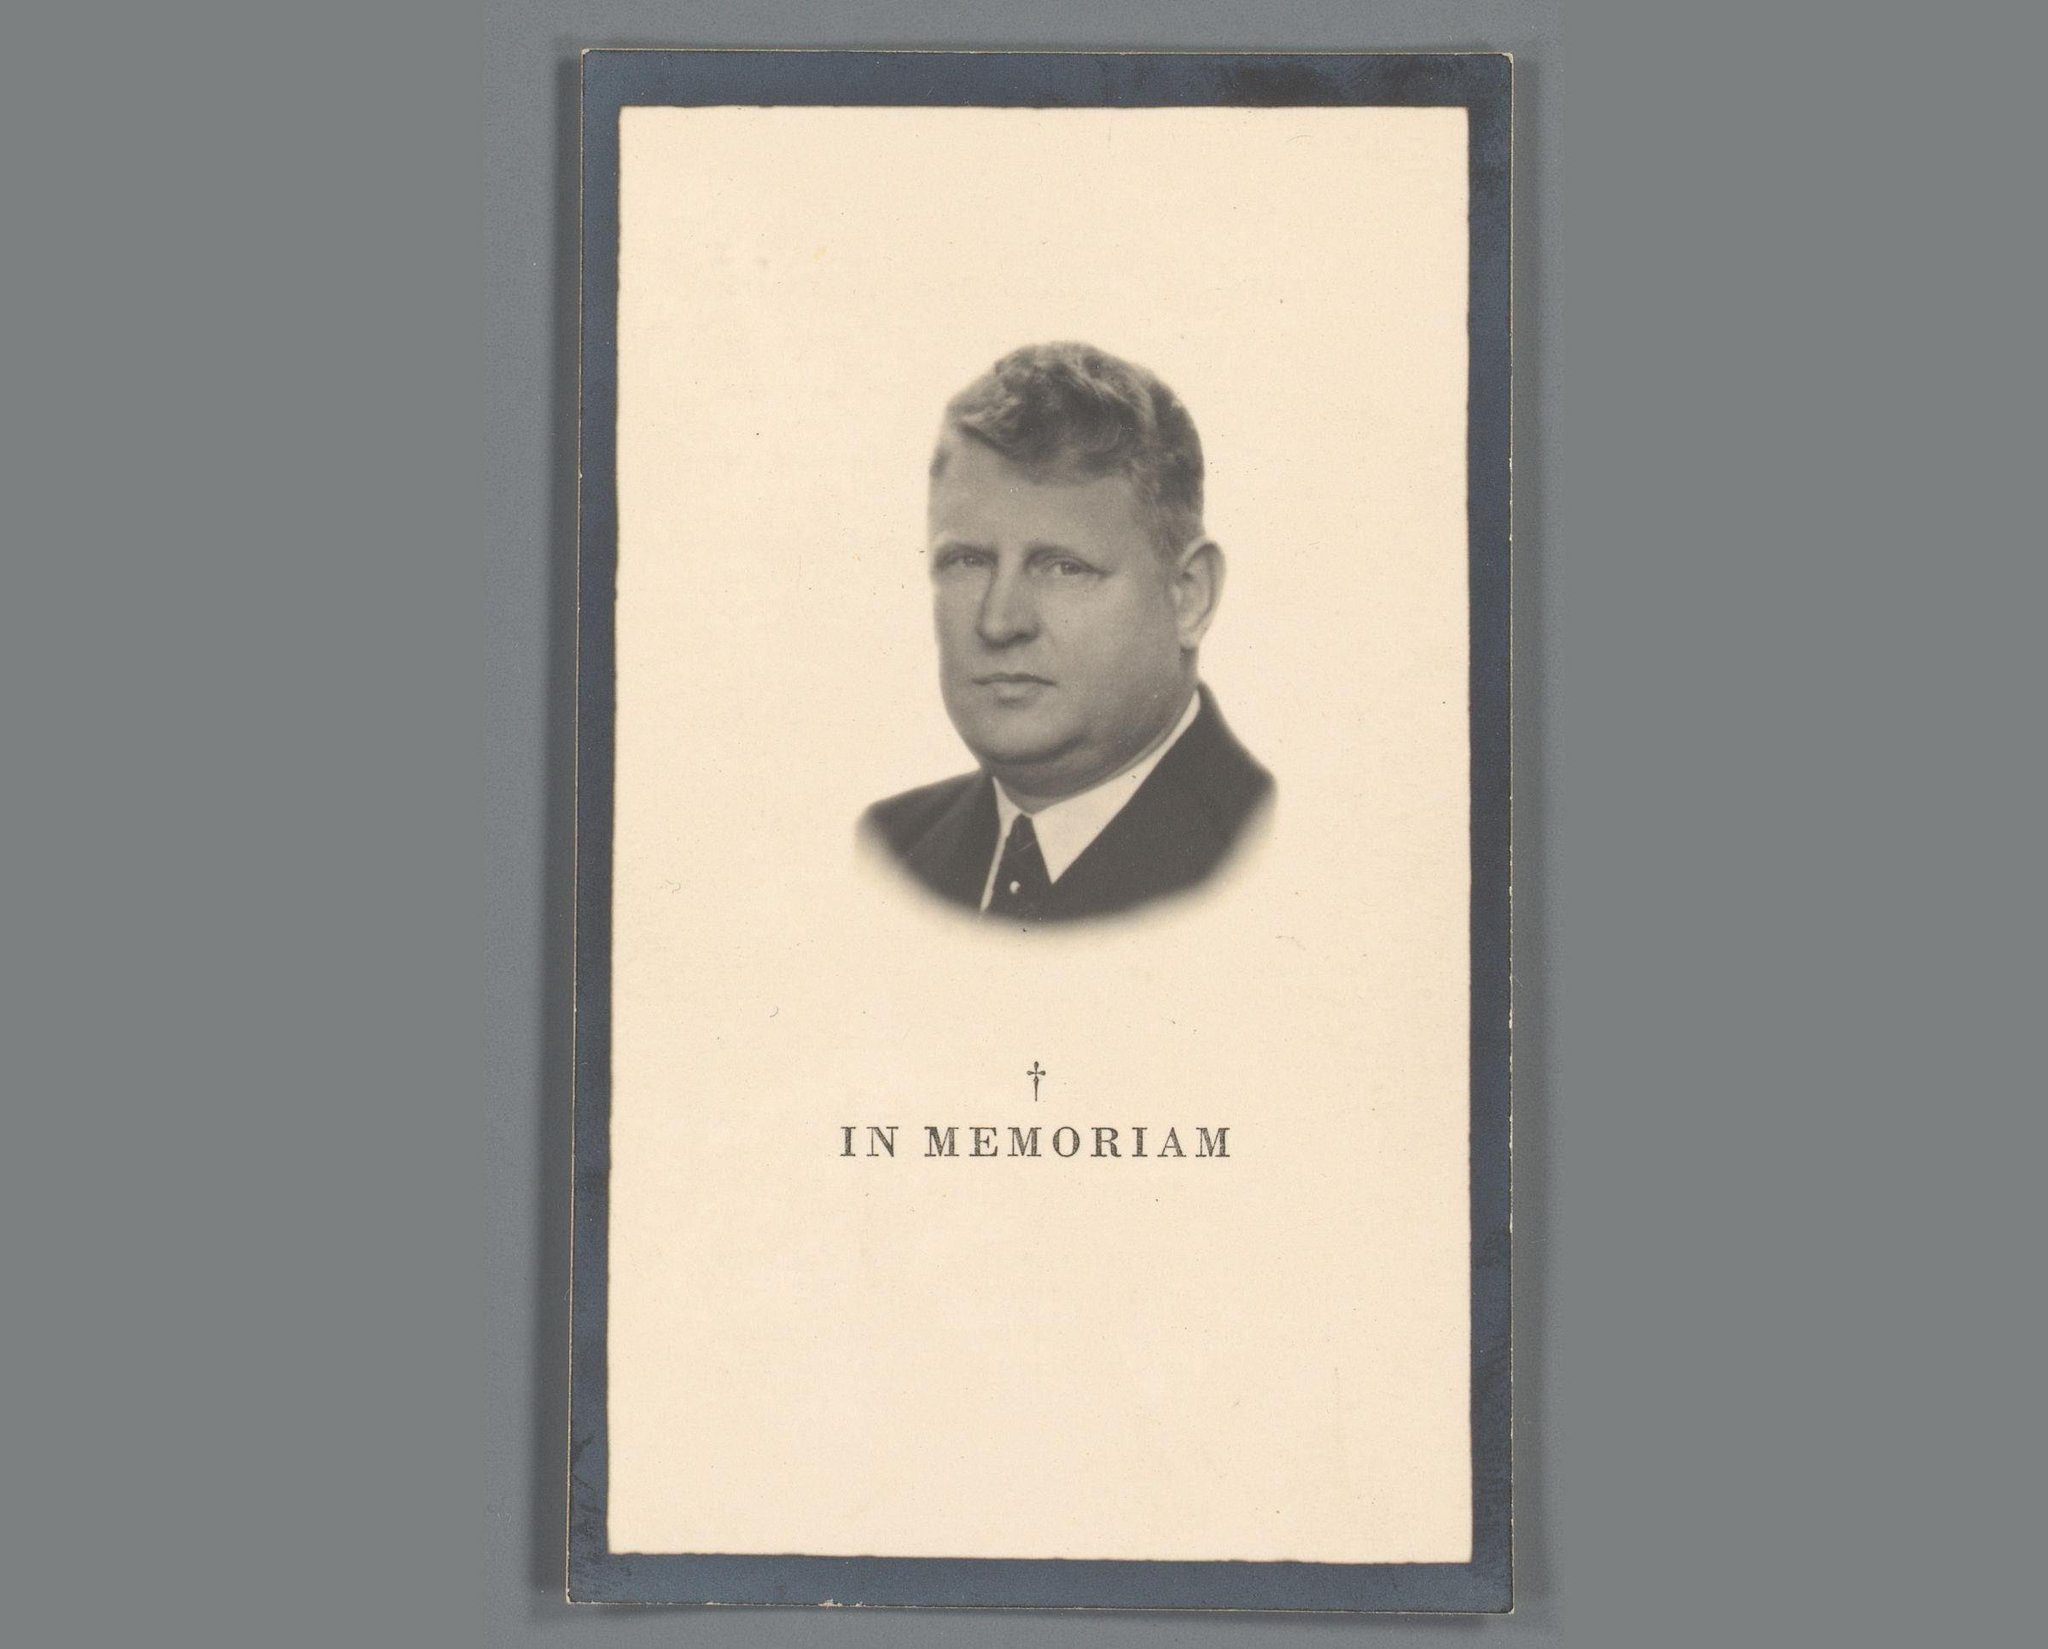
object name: prayer card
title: Portret van Gerardus Johannes Jacobs op bidprent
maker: Anonymous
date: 1947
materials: paper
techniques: gelatin silver print, letterpress printing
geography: amsterdam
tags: adult man, historical persons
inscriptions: inscription: ‘Gedenk in uw gebed (...) Uw Hemelvrede.’